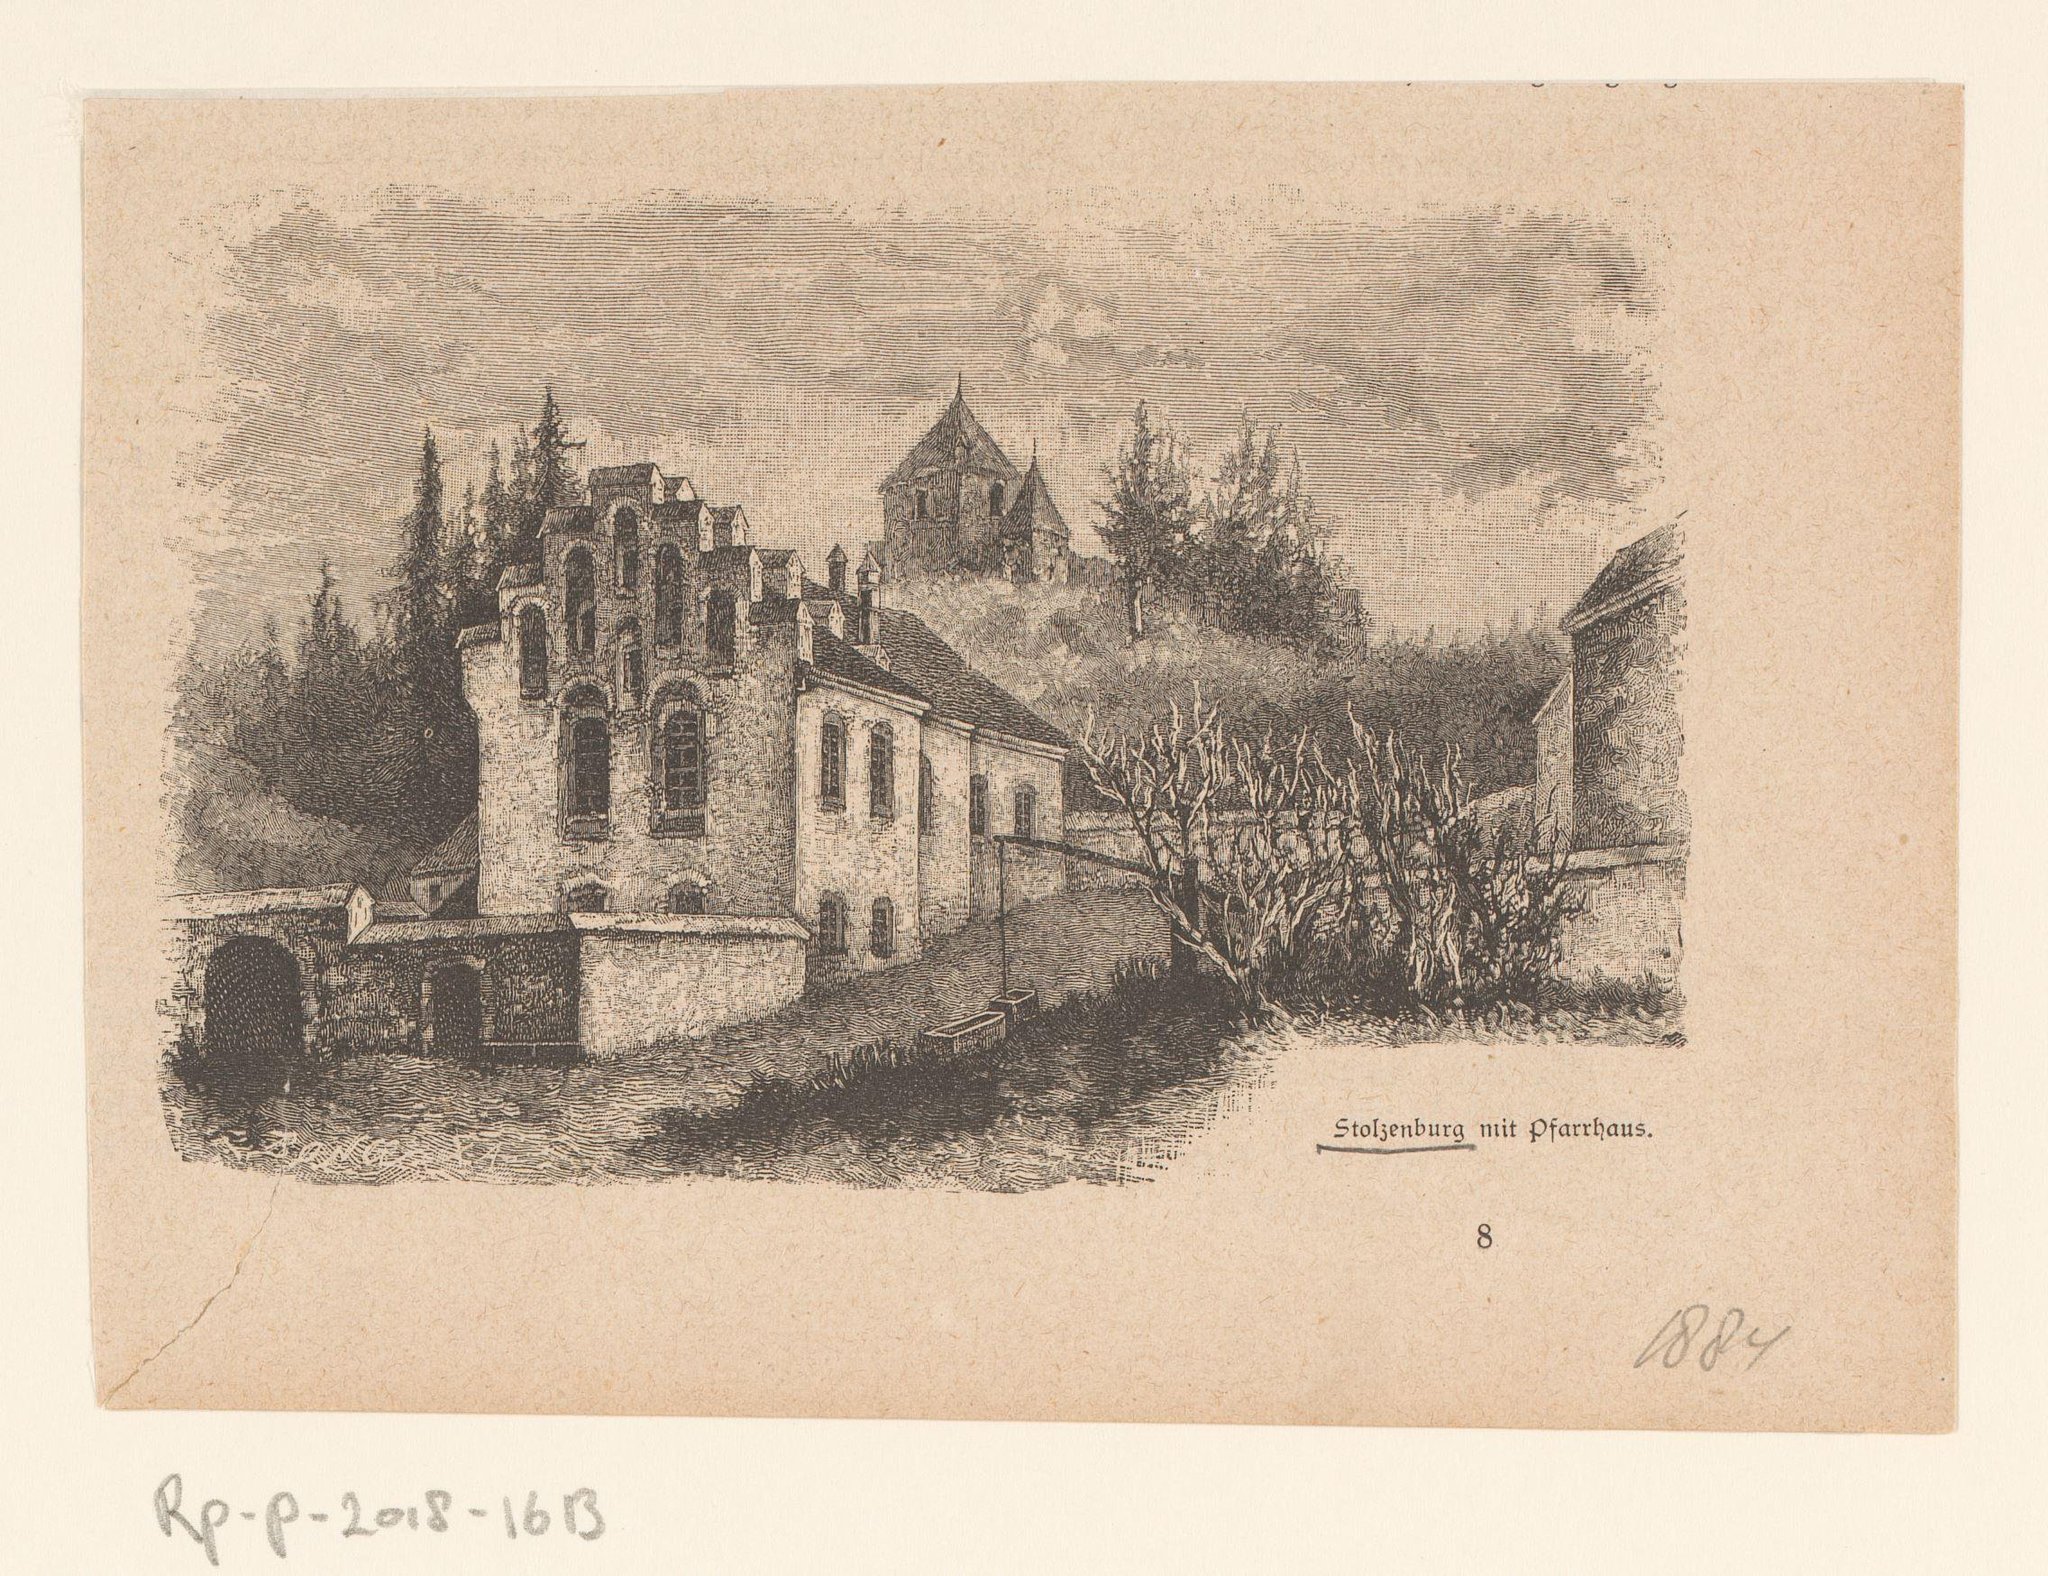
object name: print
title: Gezicht op de pastorie van Stolzenburg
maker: richard bong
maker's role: print maker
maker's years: 1853-1935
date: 1800-1899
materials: paper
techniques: letterpress printing, engraving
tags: city-gate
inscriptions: collector's mark: Lugt 2228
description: Met Duitse tekst op verso. Rechtsonder genummerd: 8.